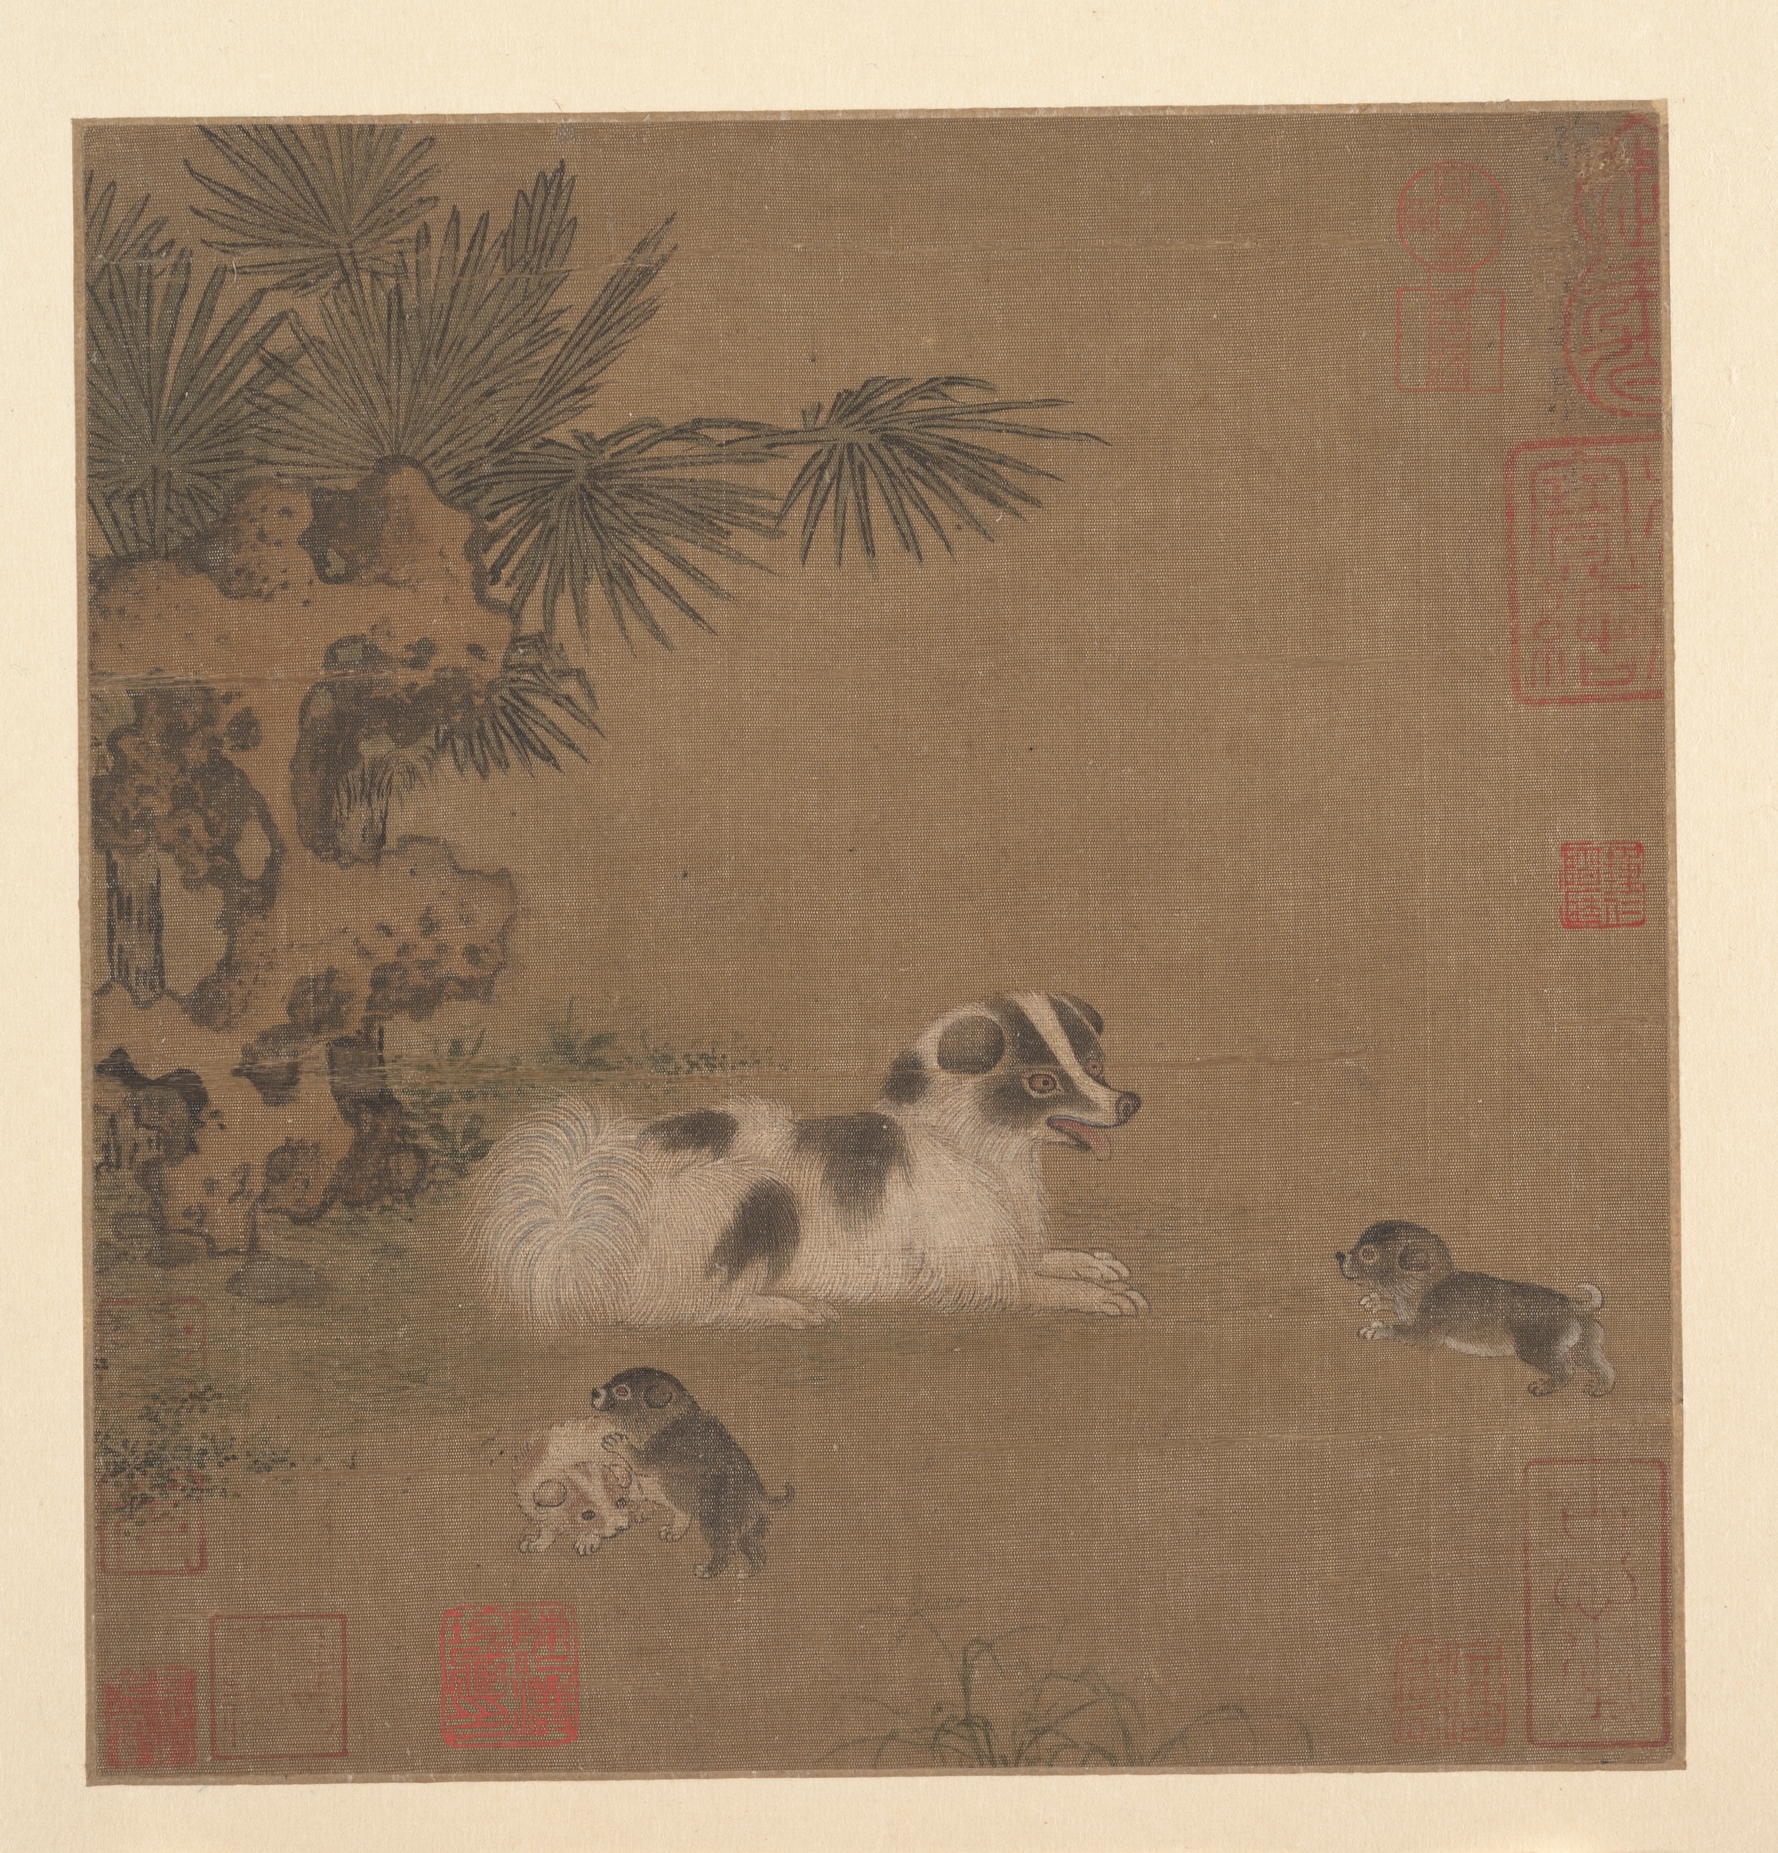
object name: album leaf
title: Puppies Playing beside a Palm Tree and Garden Rock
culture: chinese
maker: unidentified artist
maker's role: artist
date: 1401-1500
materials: ink, silk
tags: dogs